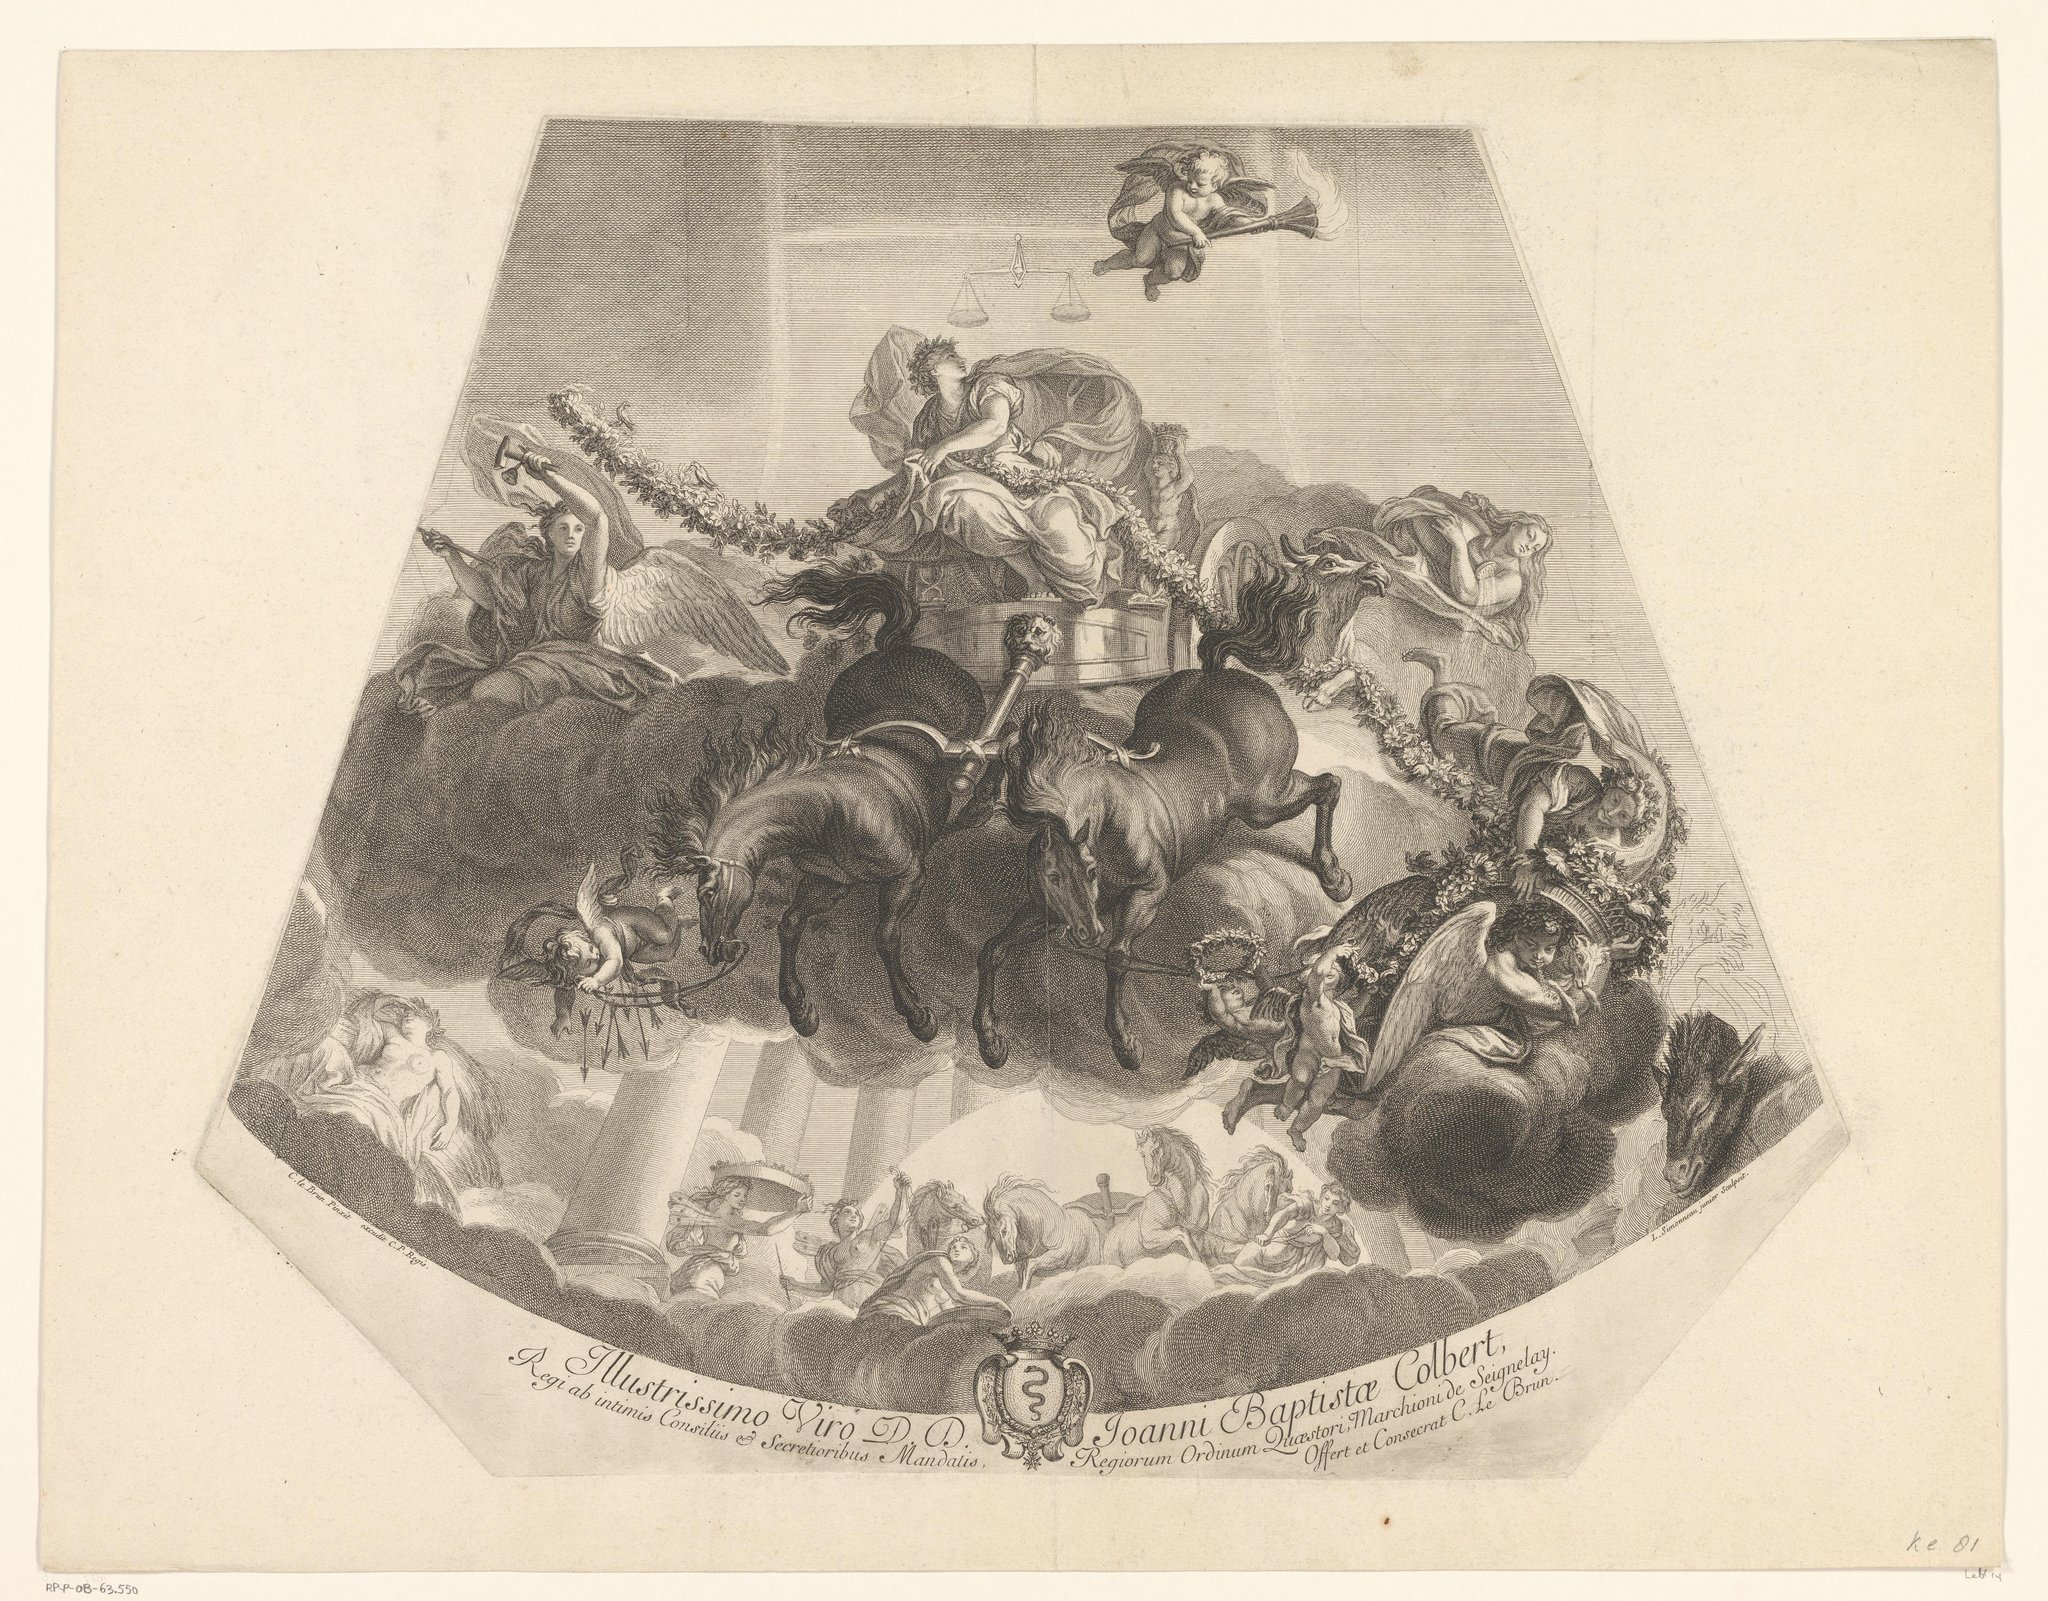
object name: print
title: Aurora verjaagt de nacht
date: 1673-1683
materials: paper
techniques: engraving, etching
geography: france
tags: triumph of aurora: in her chariot drawn by two (sometimes four) horses, and possibly scattering flowers; aurora's victory over the night; 'carro dell'aurora' (ripa)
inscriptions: collector's mark: Lugt 2228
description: Naar een plafondschildering van het paviljoen van Aurora in kasteel de Sceaux, uitgevoerd in ca. 1673-1674.